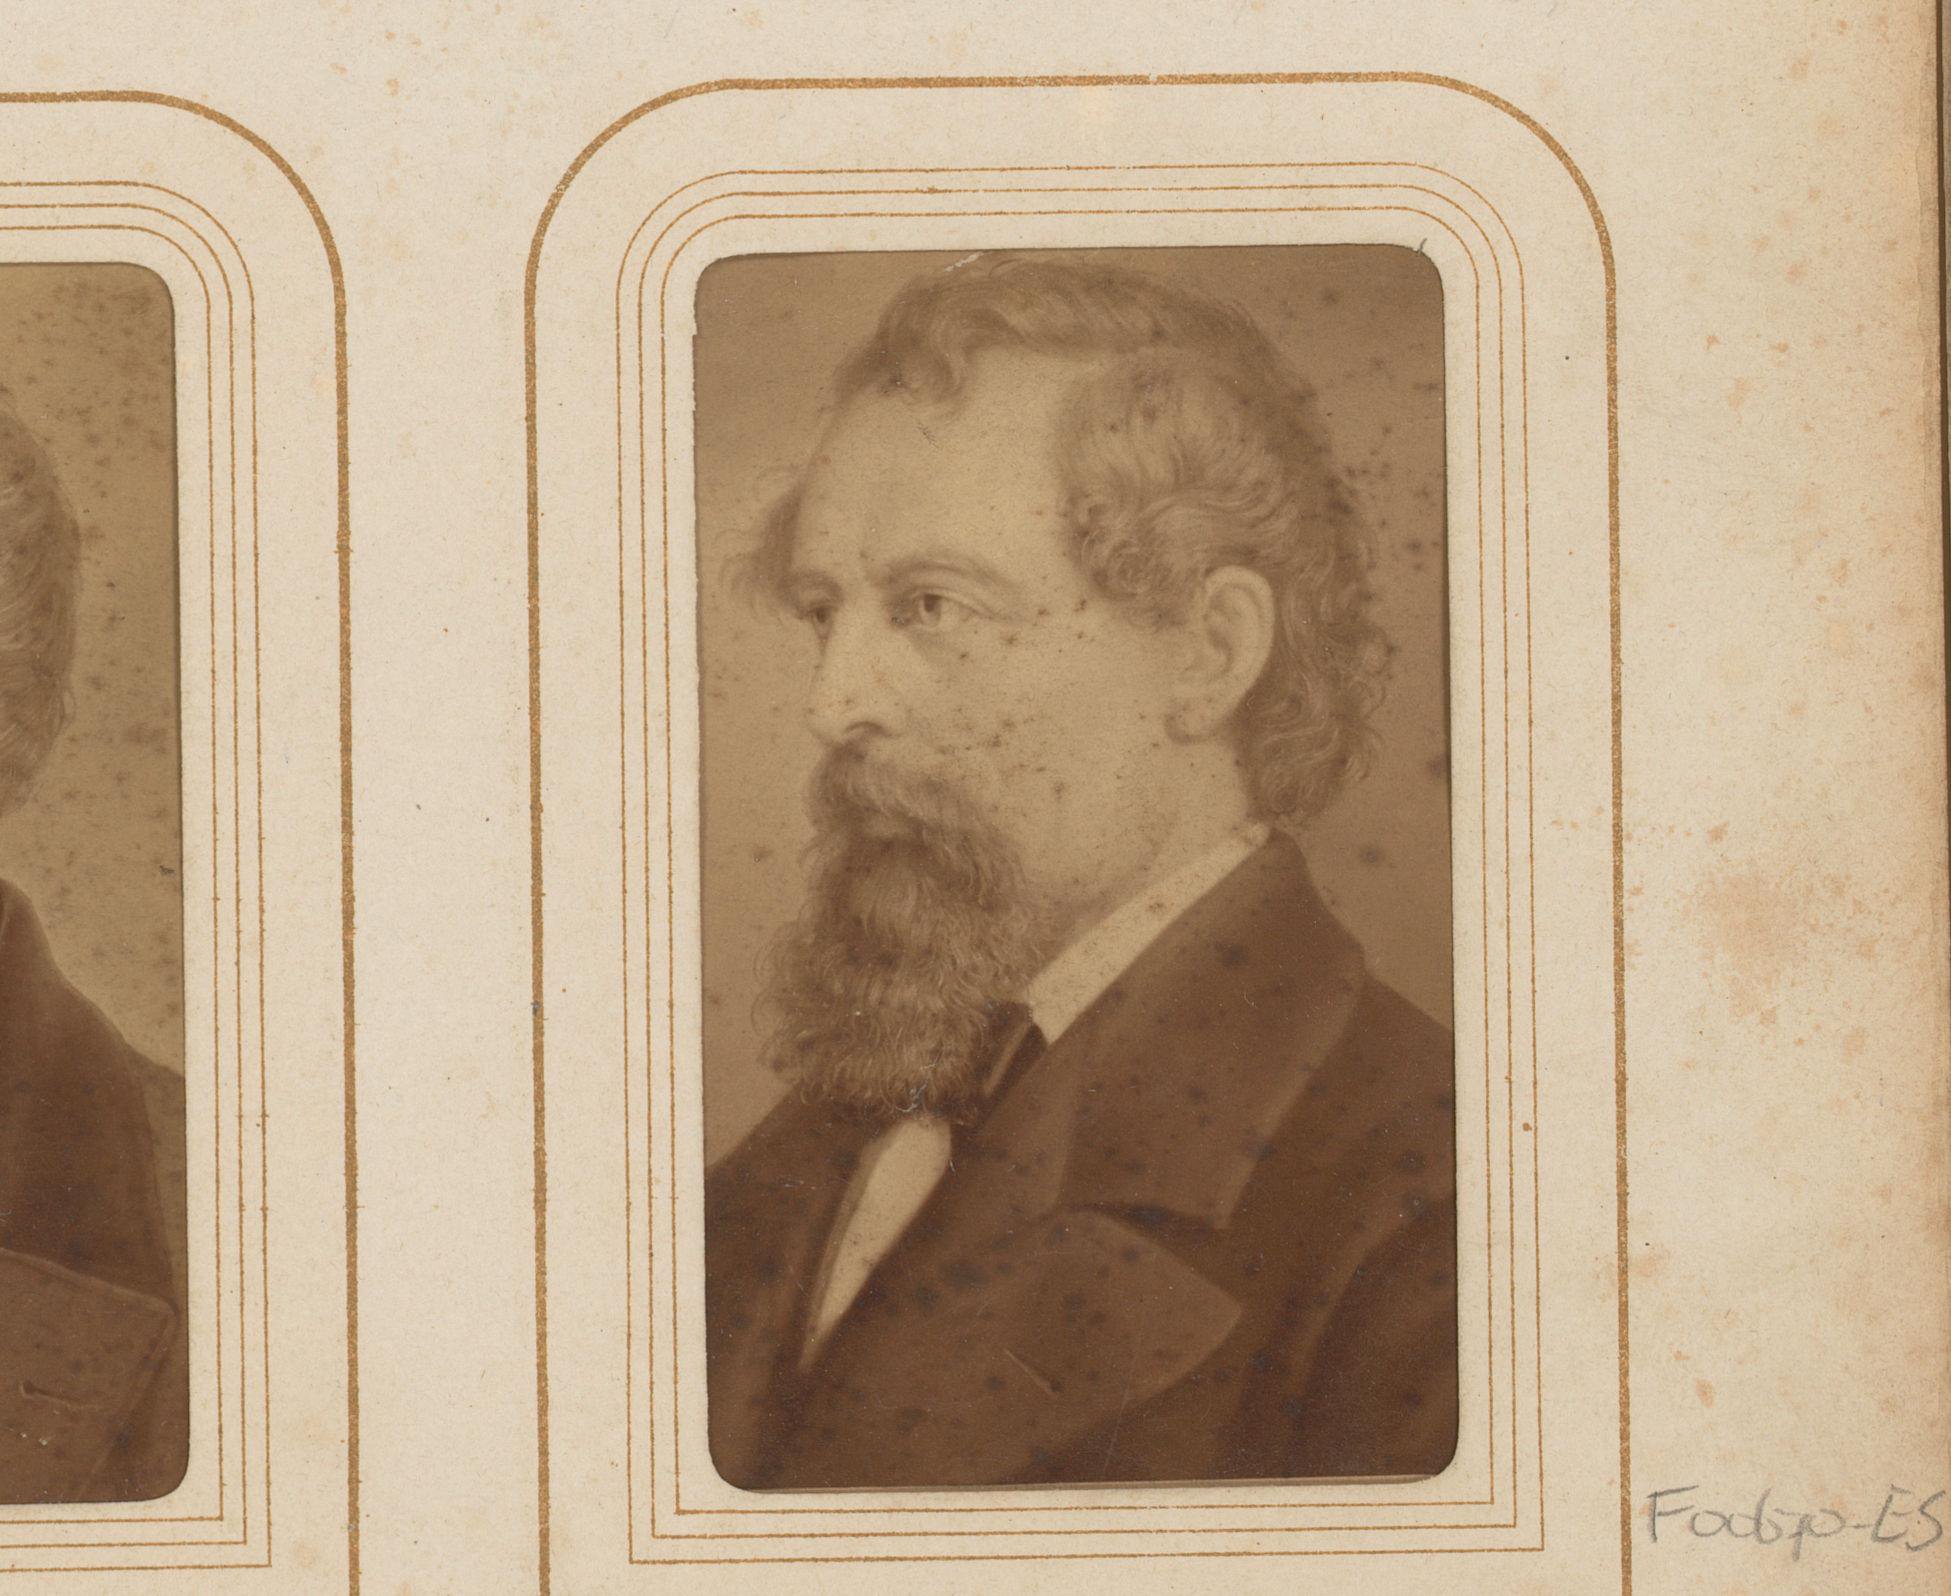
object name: reproduction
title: Fotoreproductie van een geschilderd portret van Charles Dickens naar Ernst Hader door Sophus Williams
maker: sophus williams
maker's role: publisher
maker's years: 1835-1900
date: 1877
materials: cardboard, photographic support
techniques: albumen print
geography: berlin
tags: portsmouth, historical persons, writer, poet, author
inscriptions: annotation: ‘Charles Dickens 1812-1870’